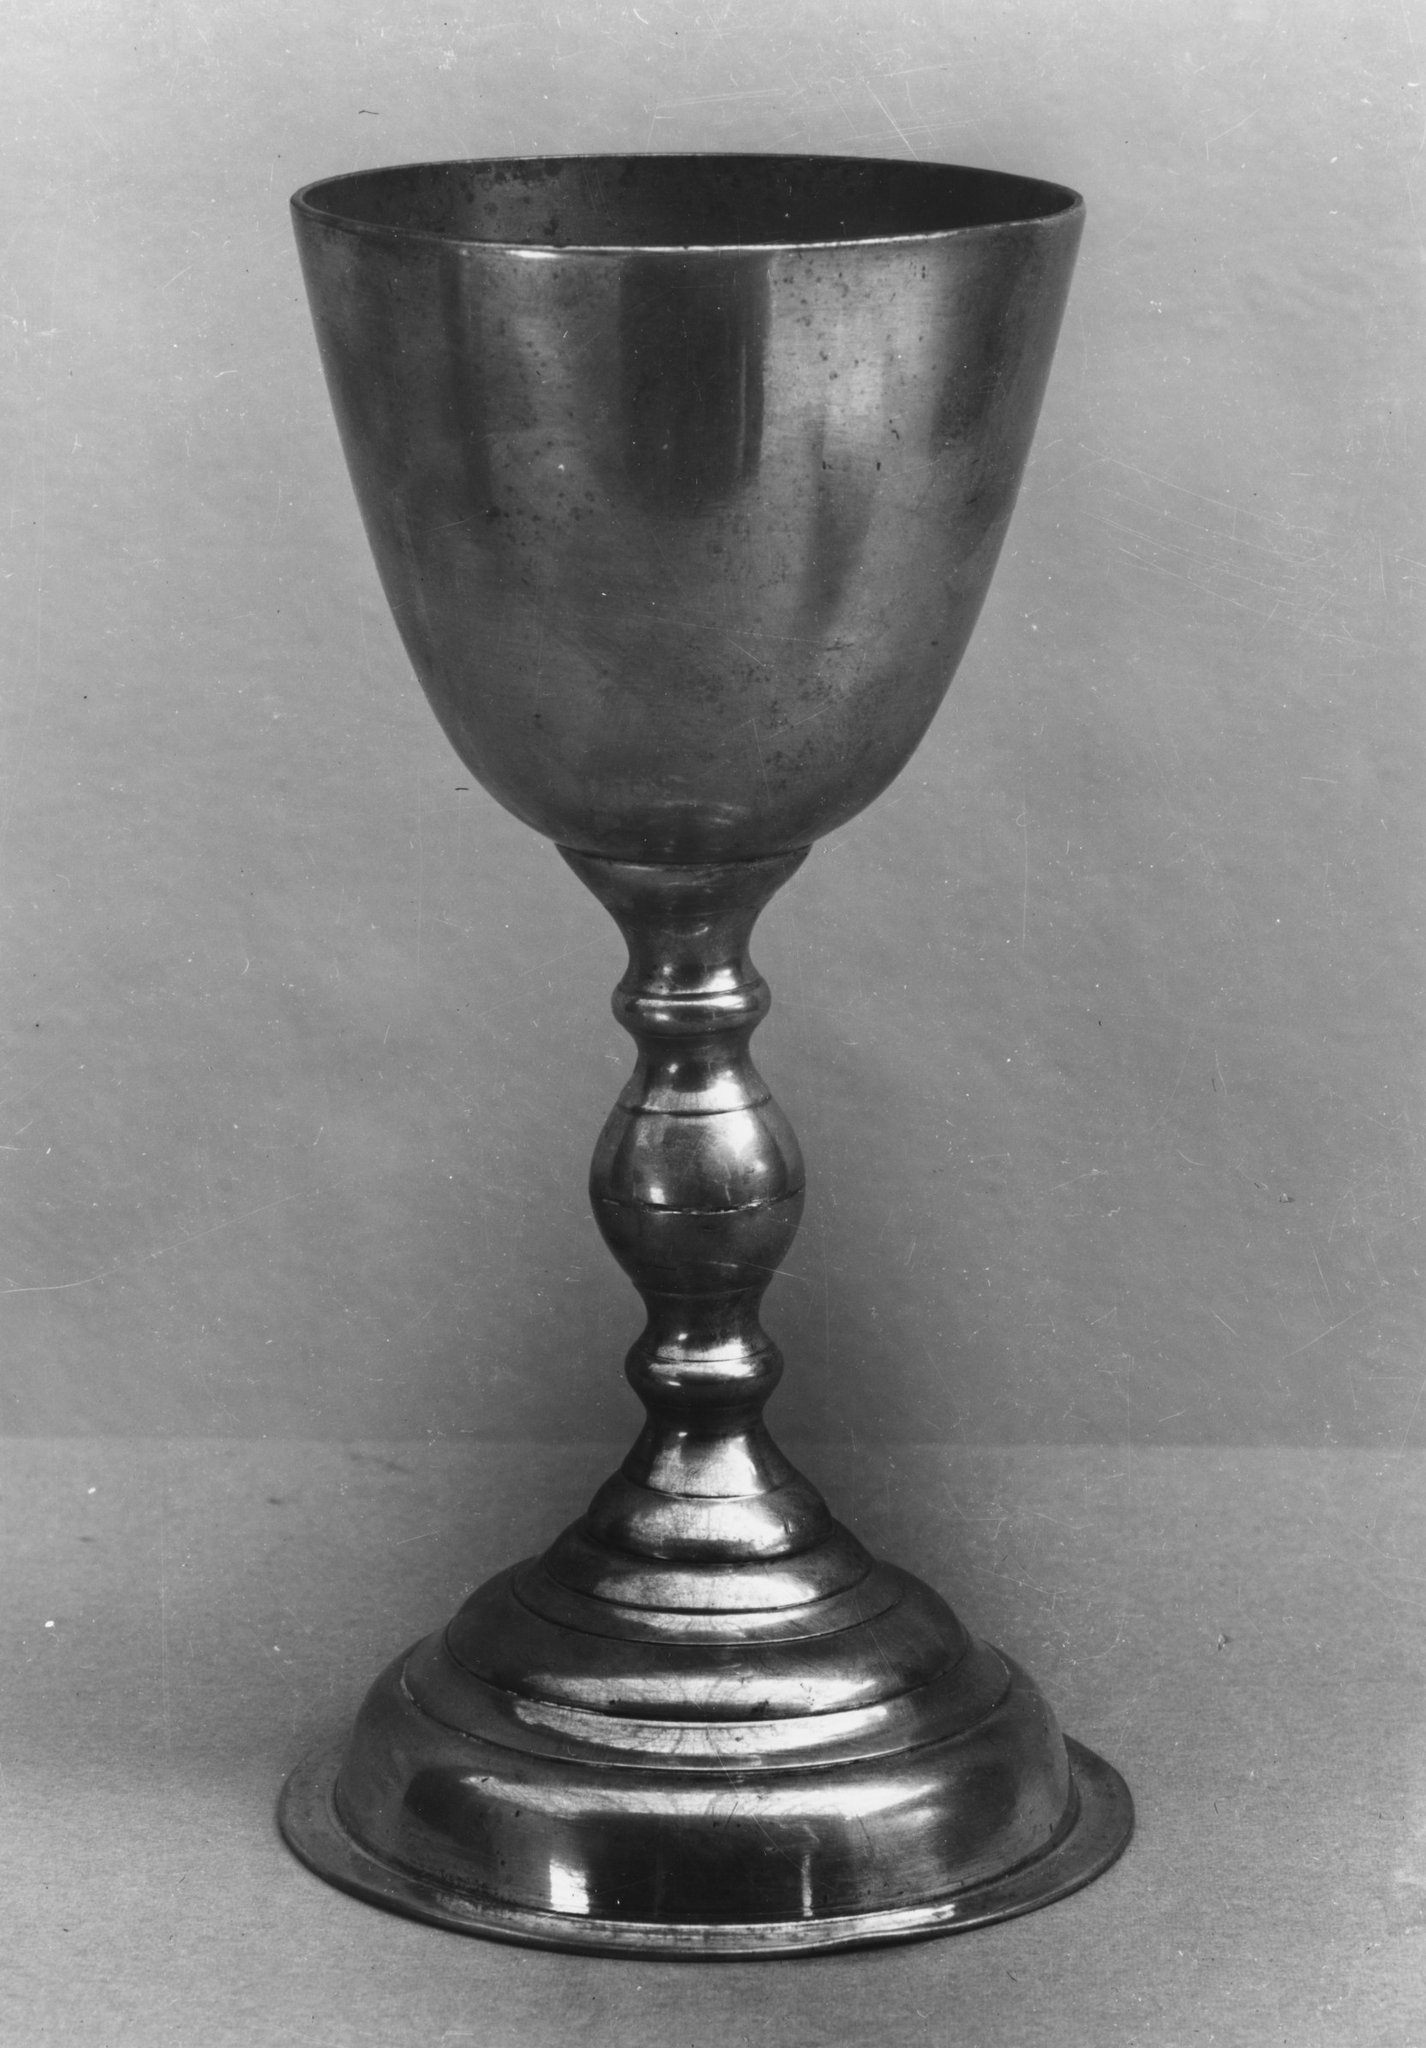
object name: chalice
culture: american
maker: timothy bridgen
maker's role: maker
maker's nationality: american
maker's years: 1774-1819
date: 1816-1819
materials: pewter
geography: united states